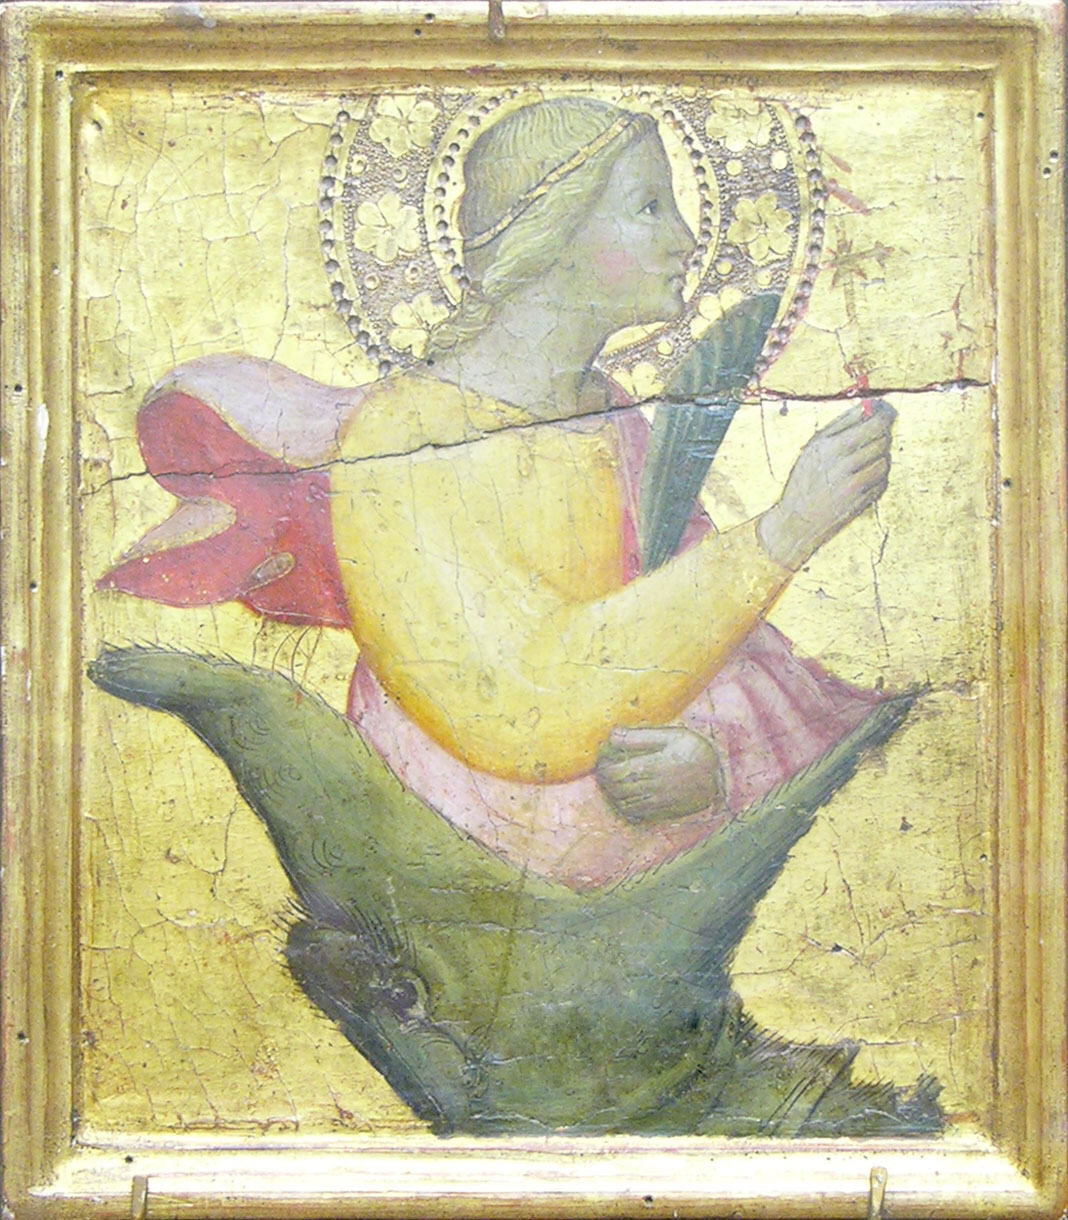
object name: painting fragment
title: Saint Margaret and the Dragon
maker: agnolo gaddi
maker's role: artist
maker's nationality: italian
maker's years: 1369-1396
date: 1390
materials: gold leaf, paint, wood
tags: women,dragons,saints